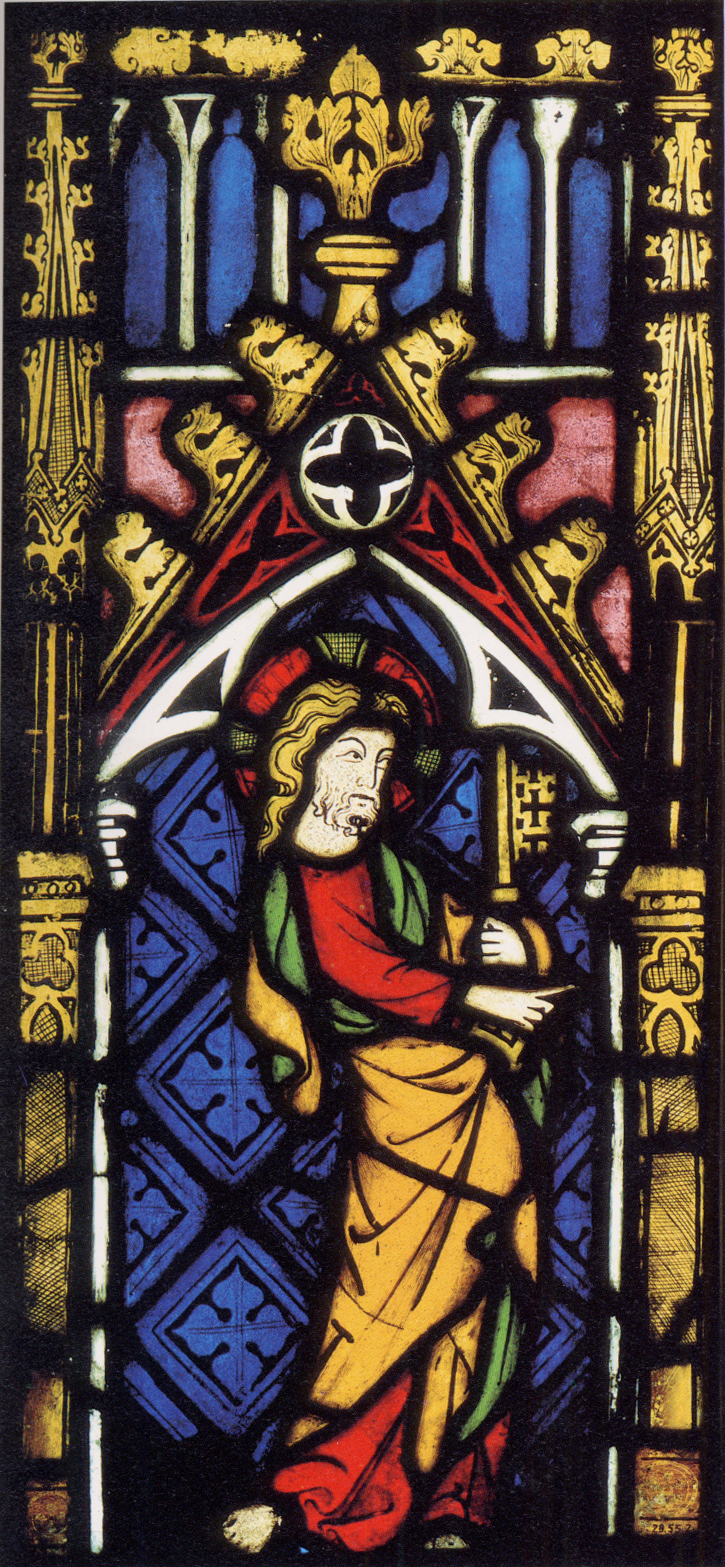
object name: panel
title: Christ Presenting the Keys to Saint Peter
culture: german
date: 1315-1320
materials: glass, lead, metal, paint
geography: germany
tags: christ,keys